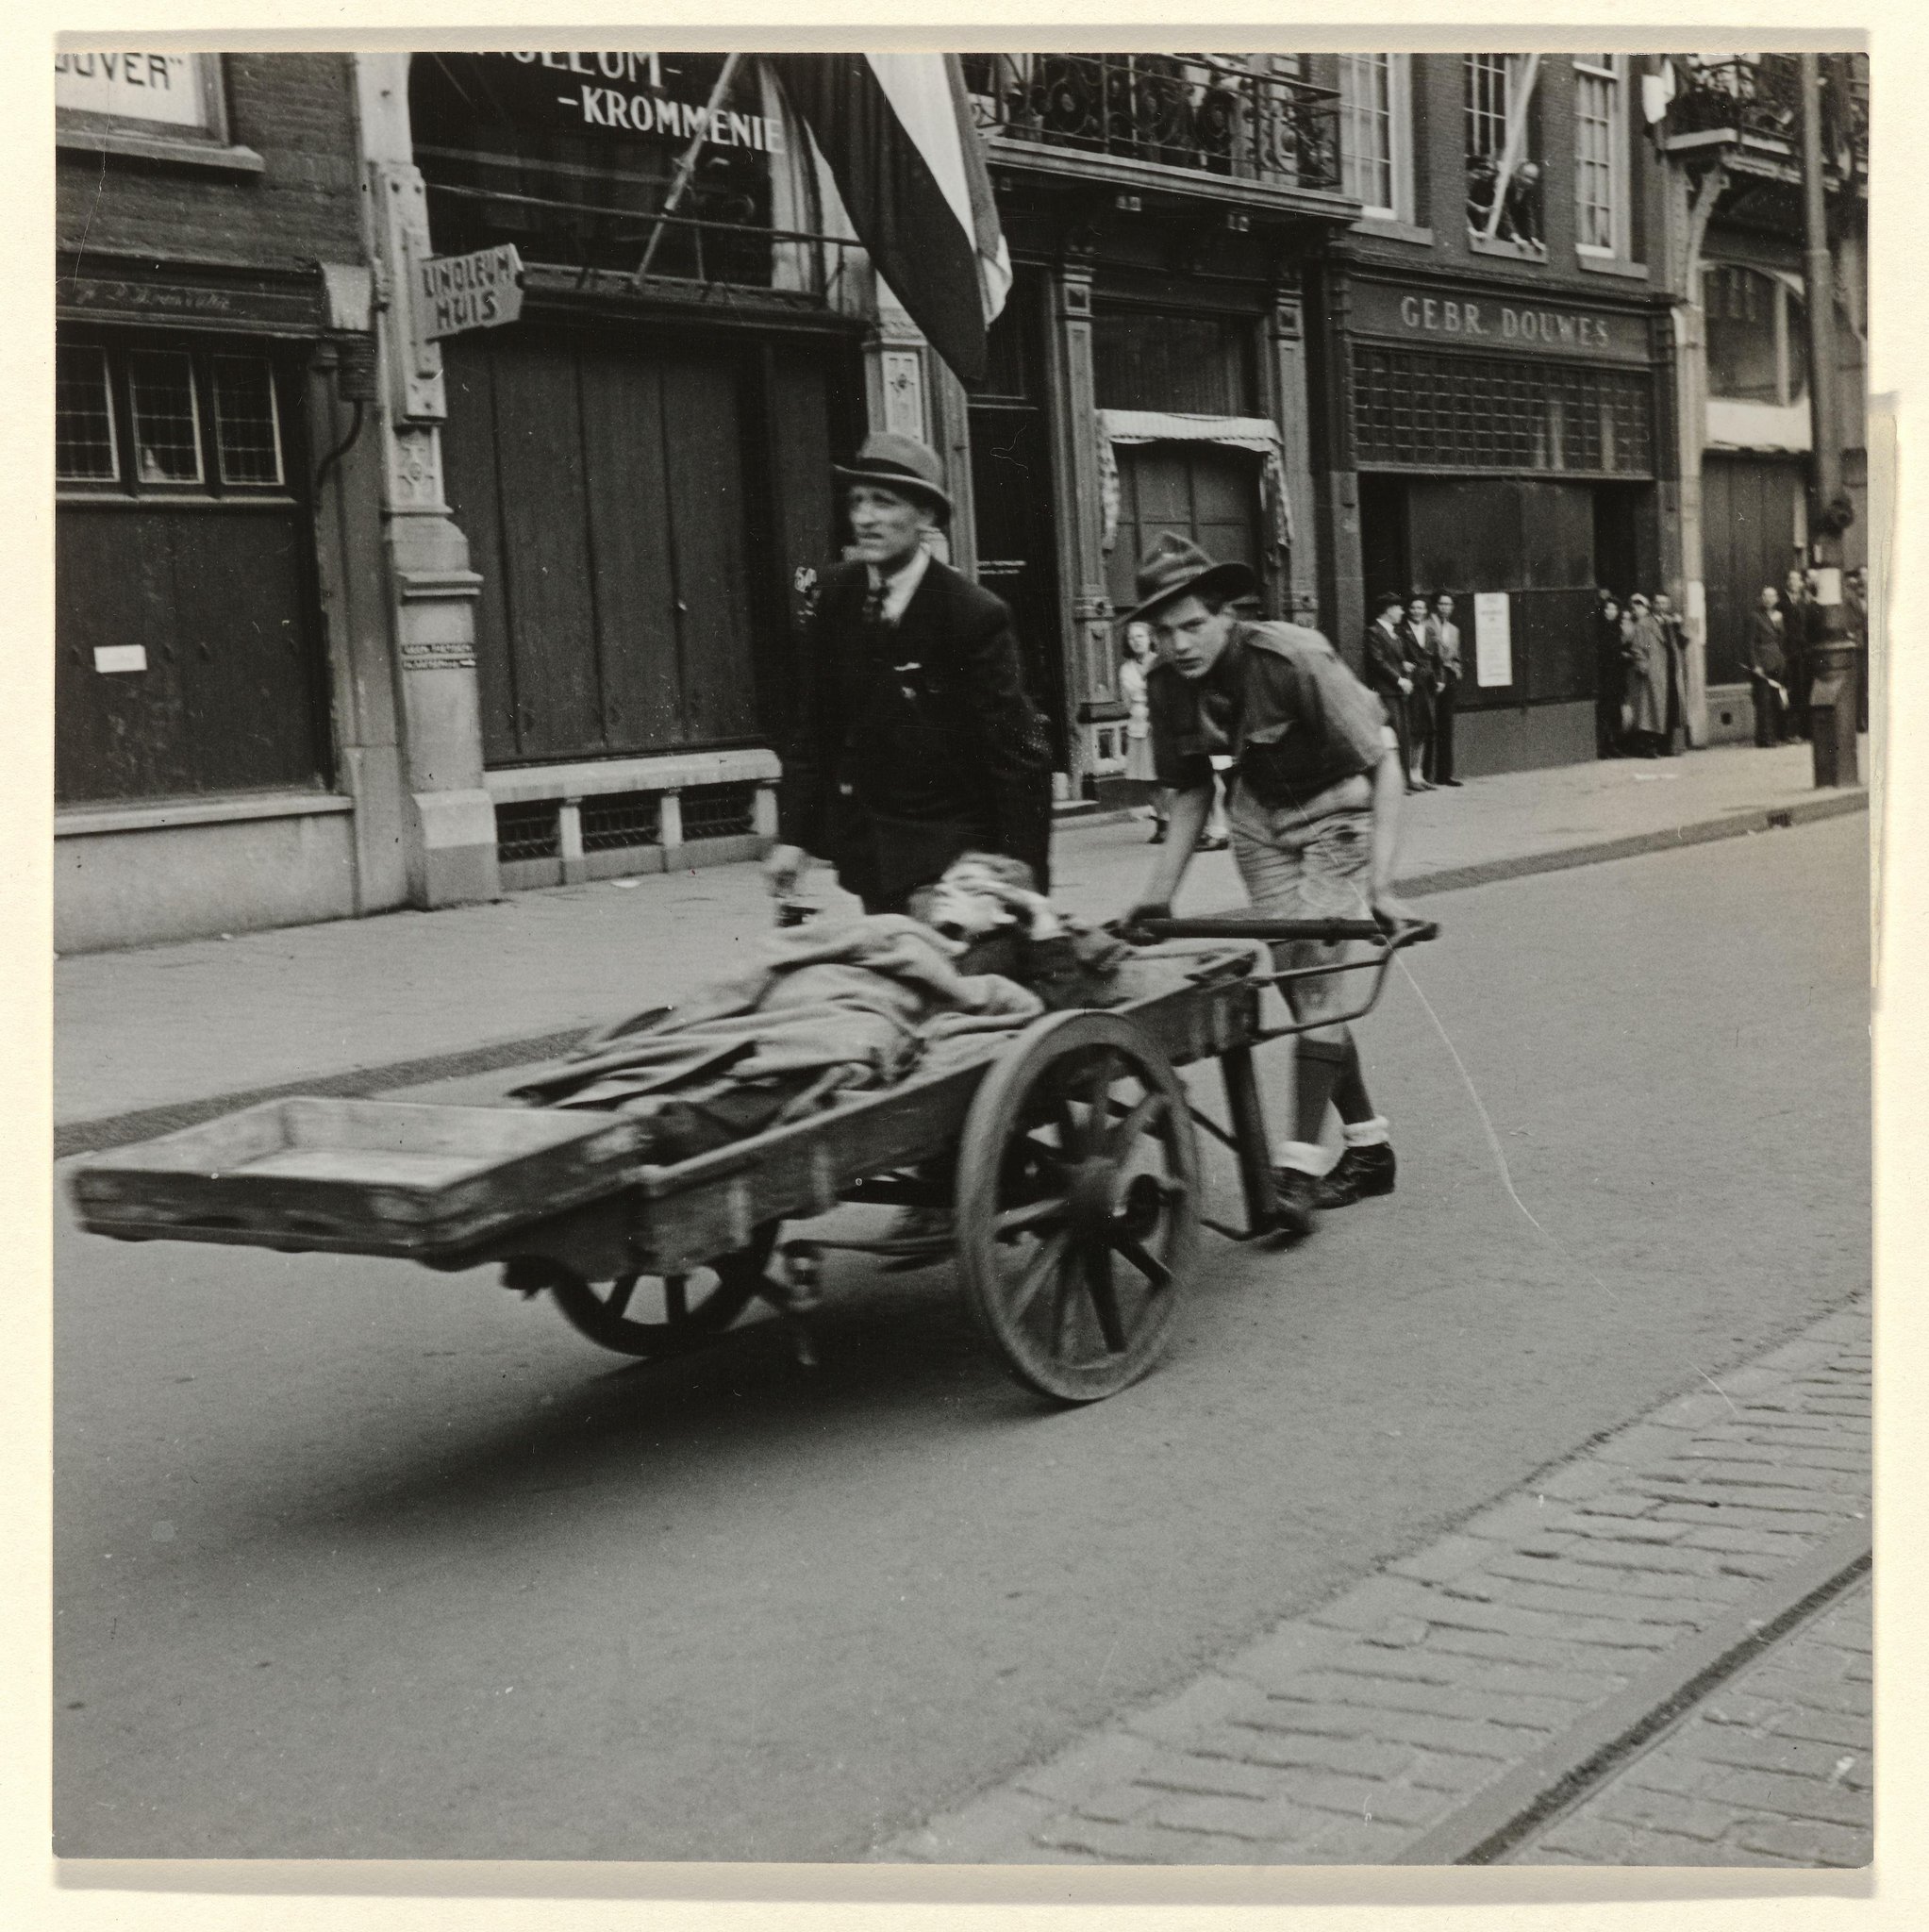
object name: documentary photograph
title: Na de beschieting op de Dam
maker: willem van de poll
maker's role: fotograaf, journalist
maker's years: 1895-1970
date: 1945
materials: photographic support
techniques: photography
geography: amsterdam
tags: amsterdam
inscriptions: number: ‘2947’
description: Padvinders bergen doden en gewonden na de beschieting op de Dam door Duitsers vanuit de Groote Club.